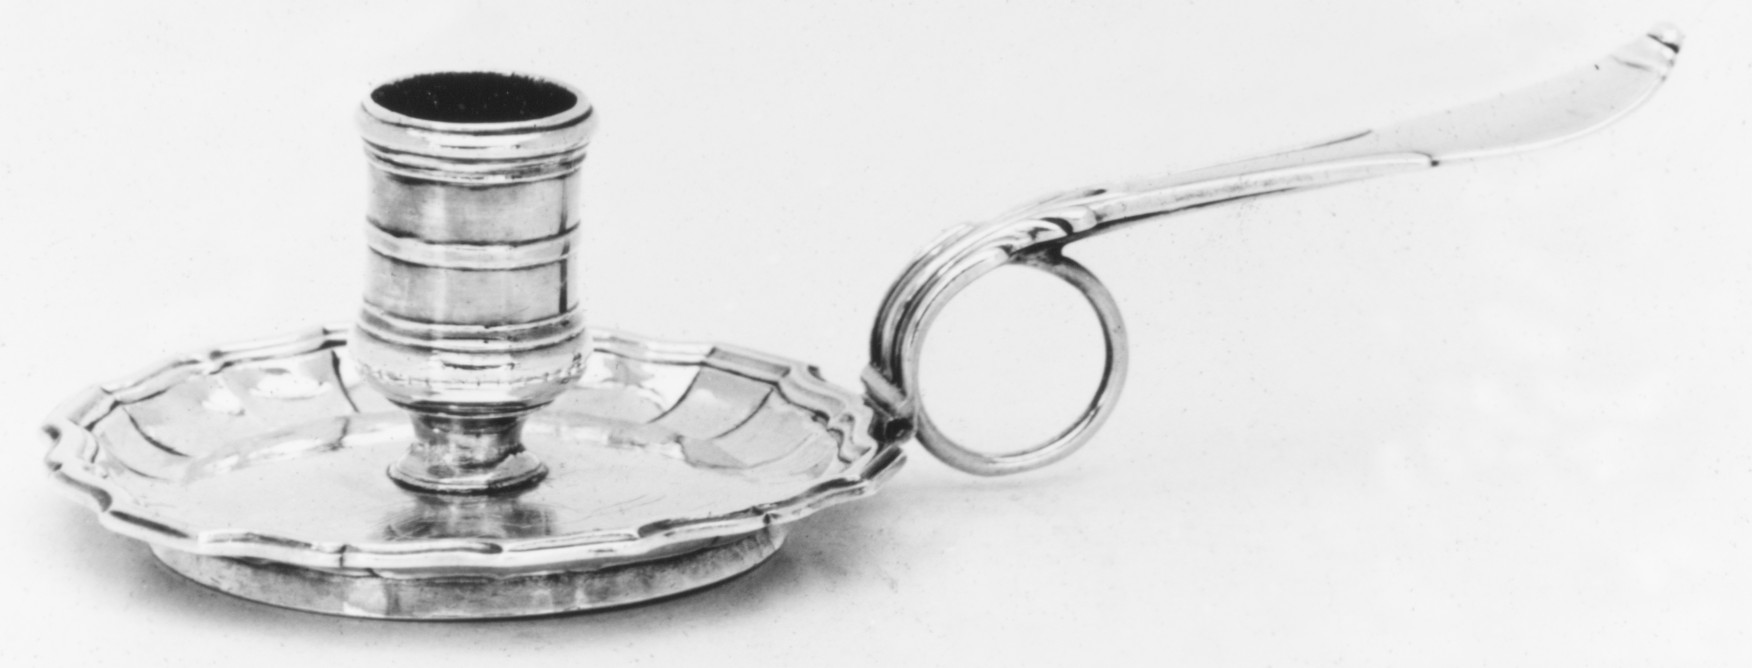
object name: chamber candlestick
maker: david herbert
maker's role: maker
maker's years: 1717-1773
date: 1760-1762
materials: silver